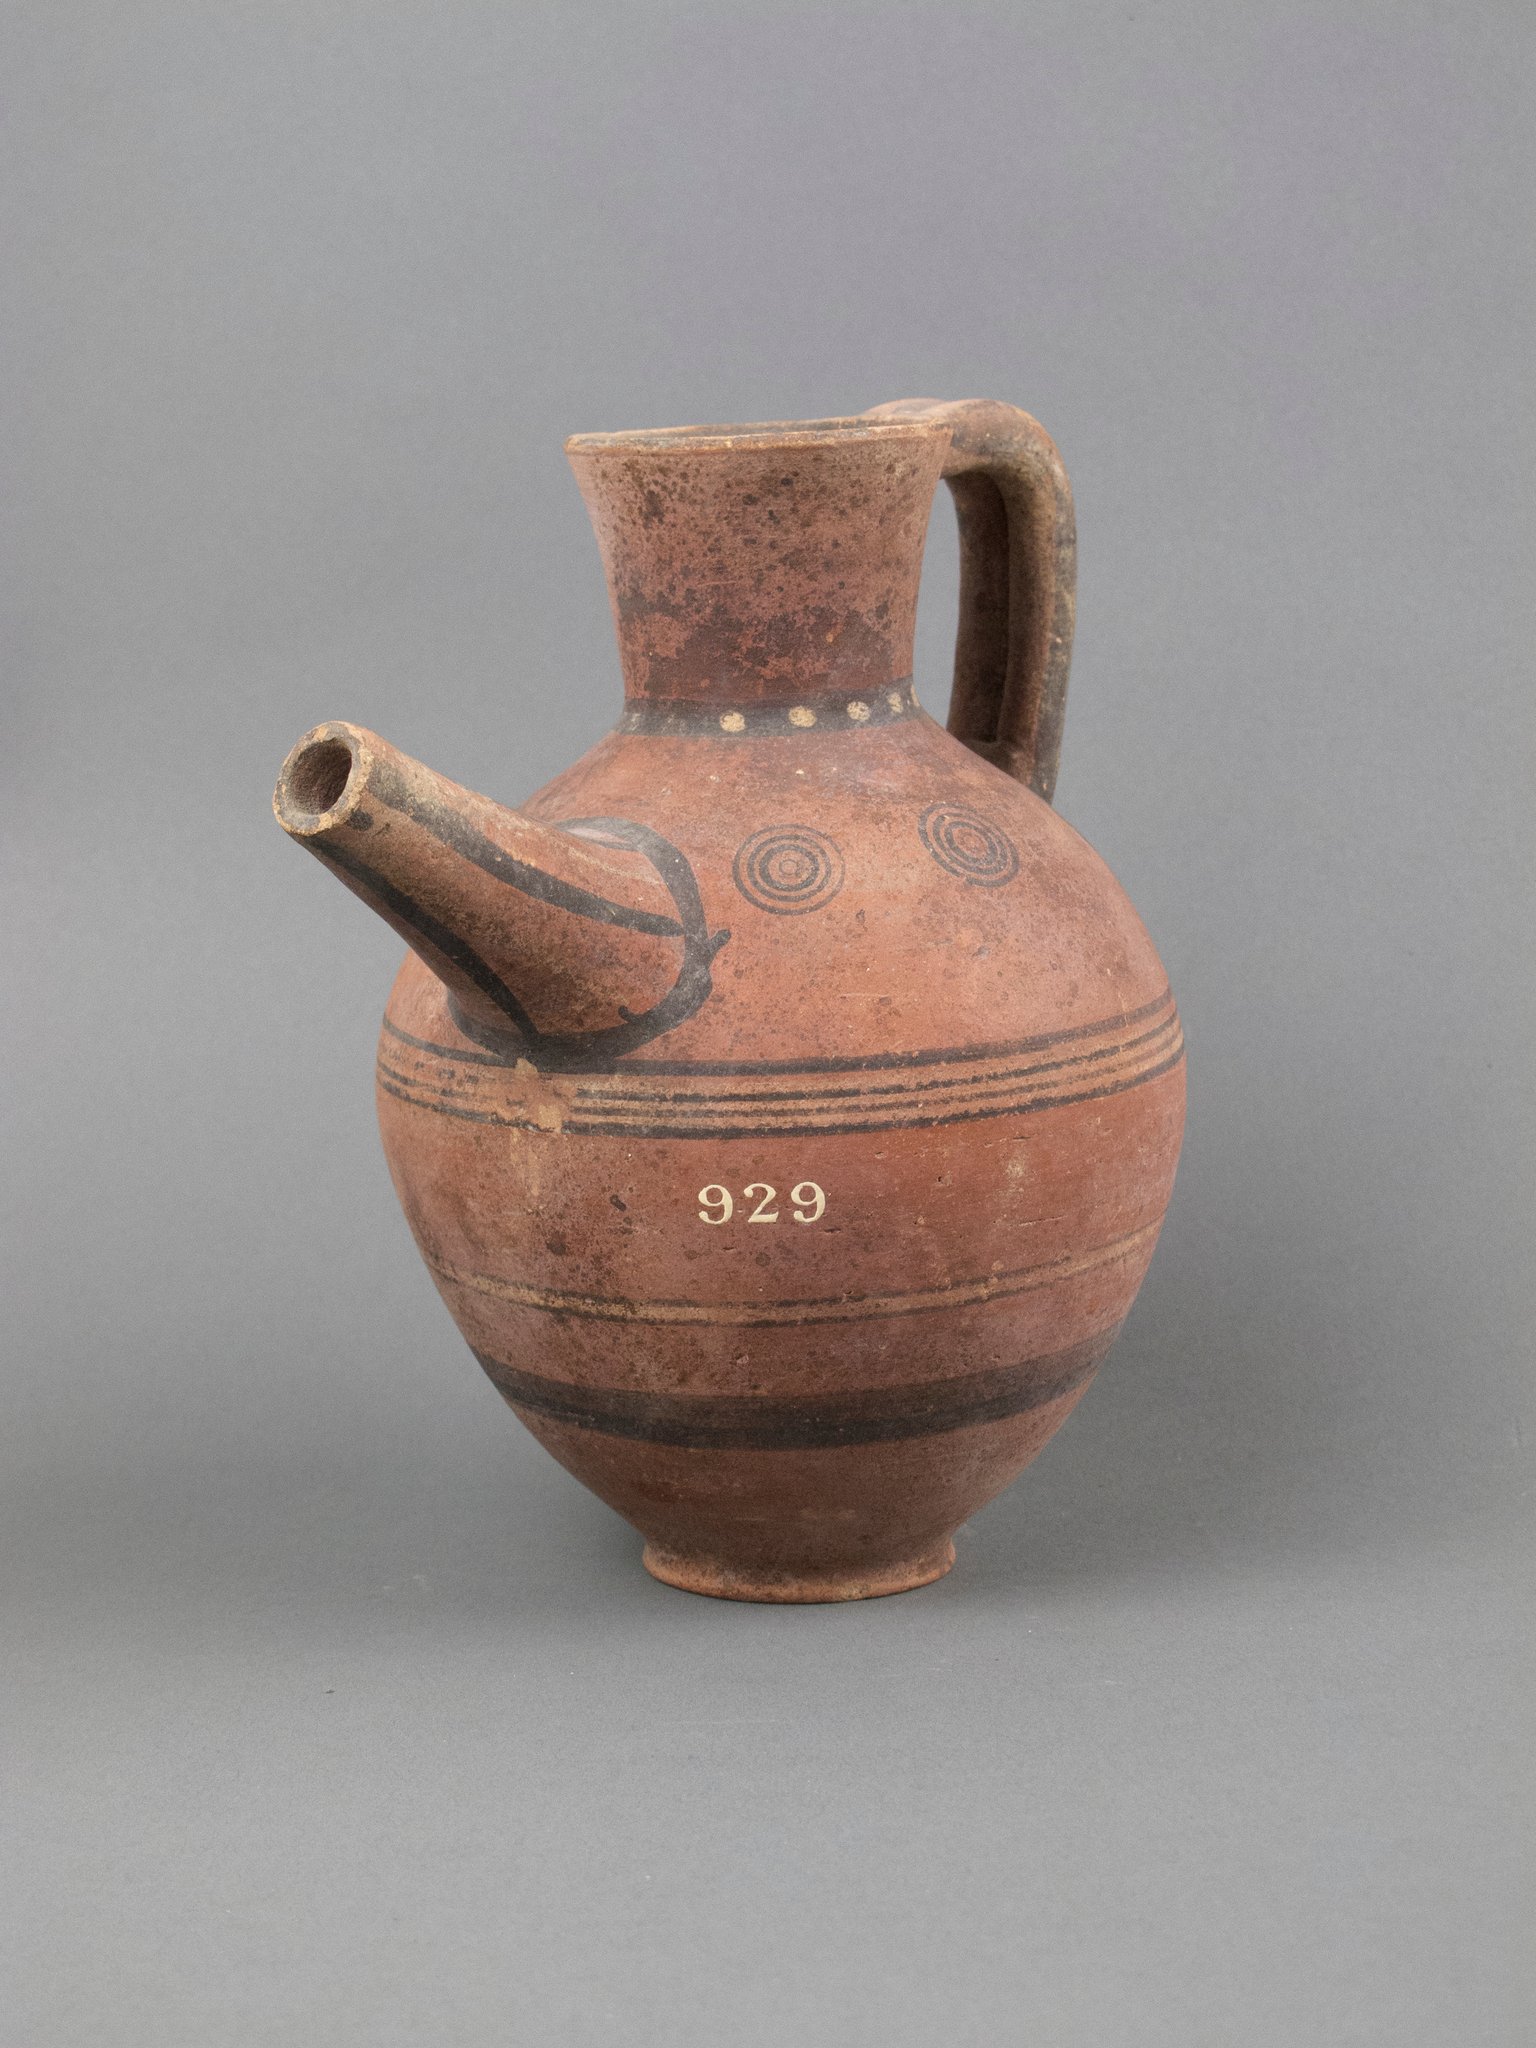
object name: jug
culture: cypriot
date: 750-600 BCE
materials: terracotta